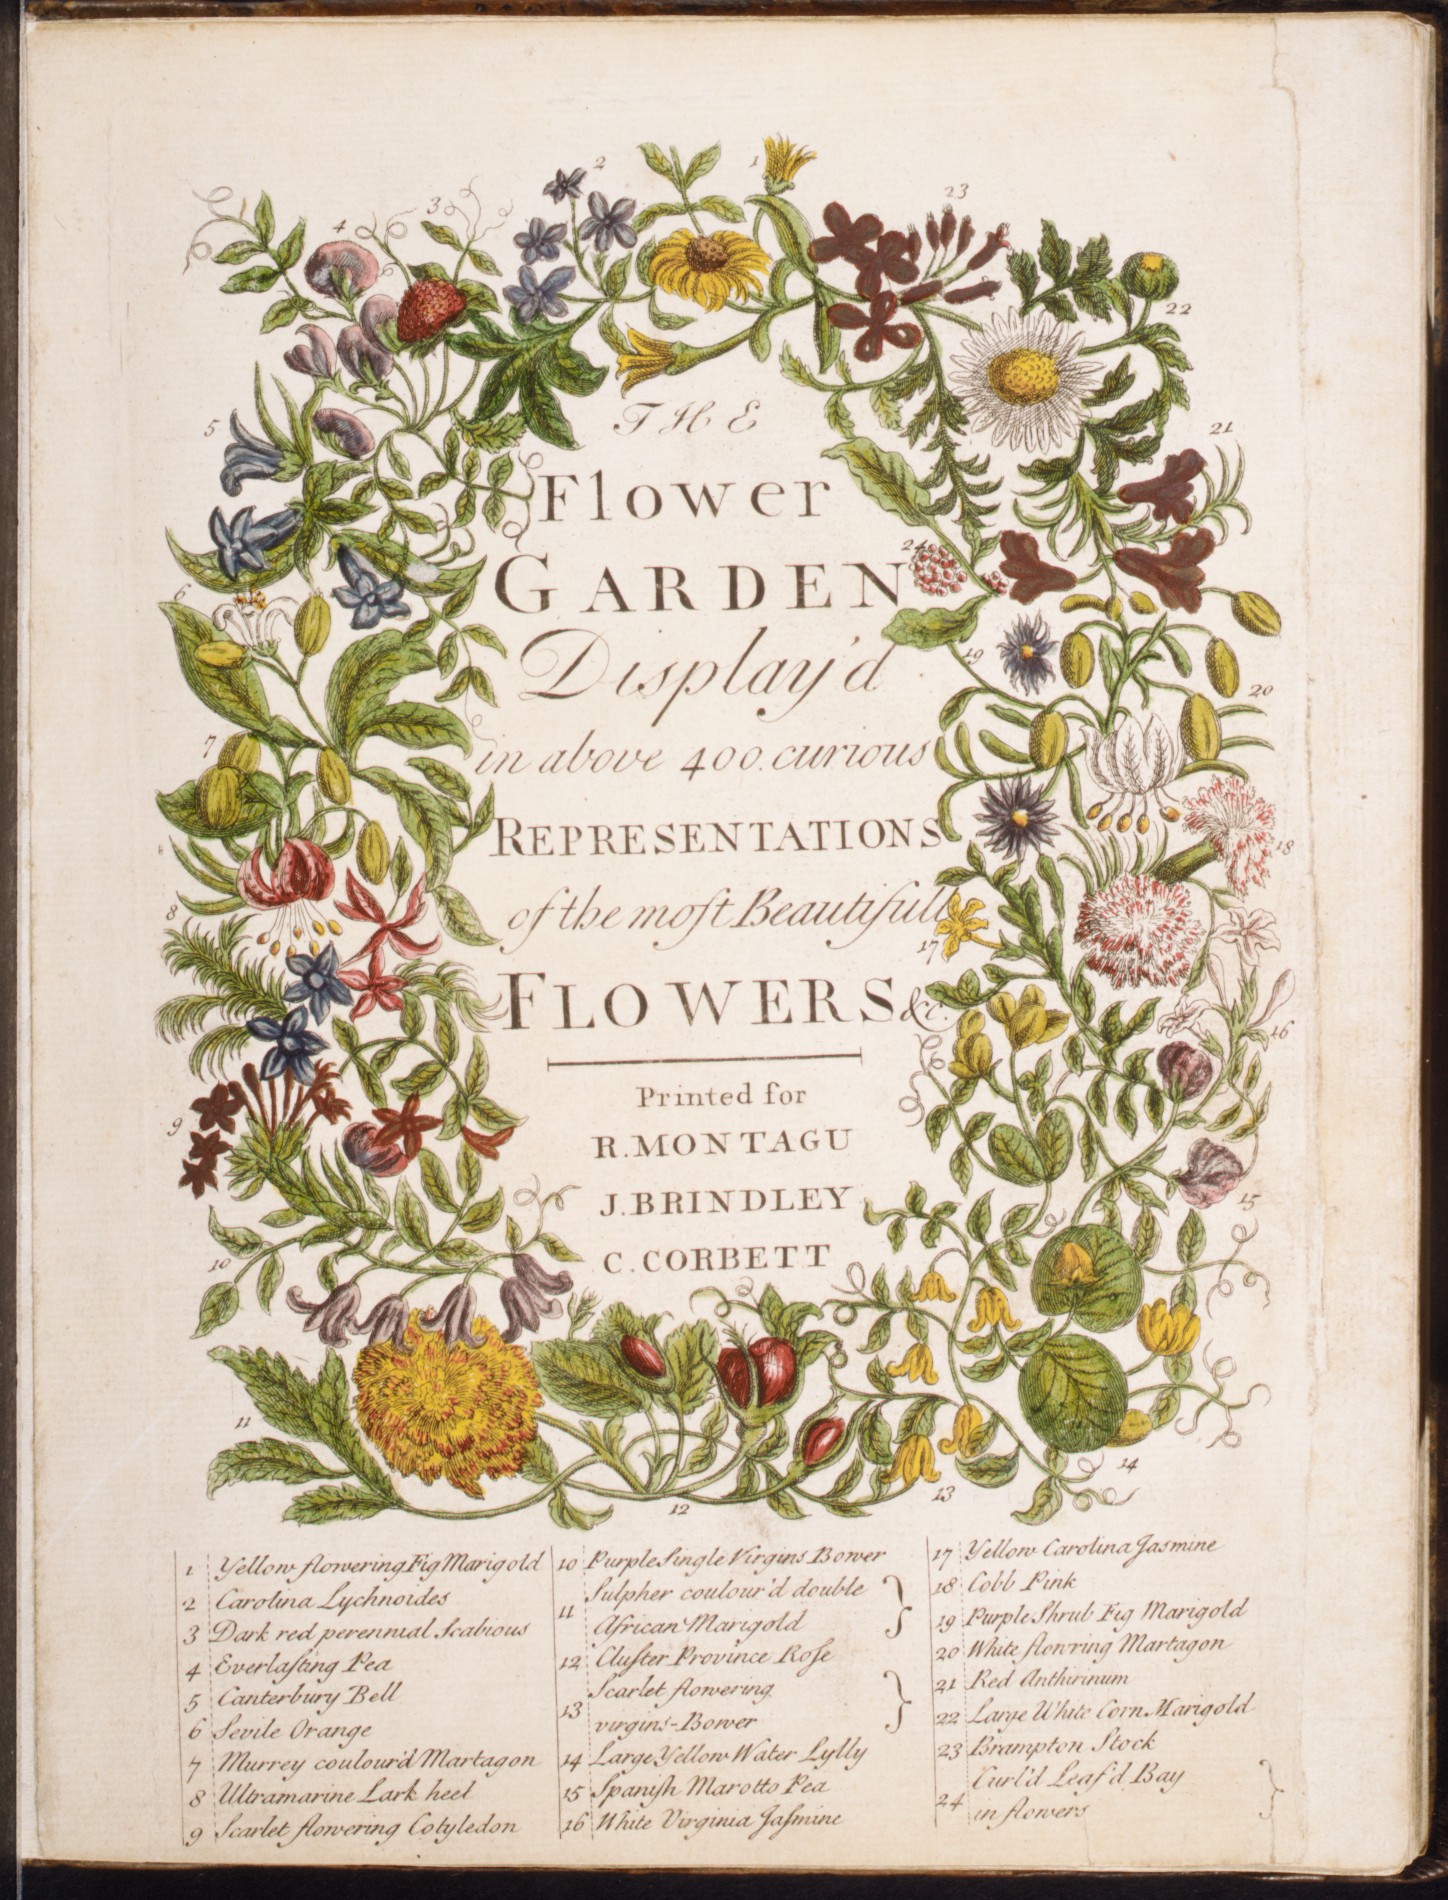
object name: book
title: The Flower-Garden Display'd, In Above Four Hundred Curious Representations Of the Most Beautiful Flowers; Regularly Dispos'd in the Respective Months of Their Bloom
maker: richard bradley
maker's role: author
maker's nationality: british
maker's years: 1688-1732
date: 1734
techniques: engraving, etching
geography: england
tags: flowers,leaves